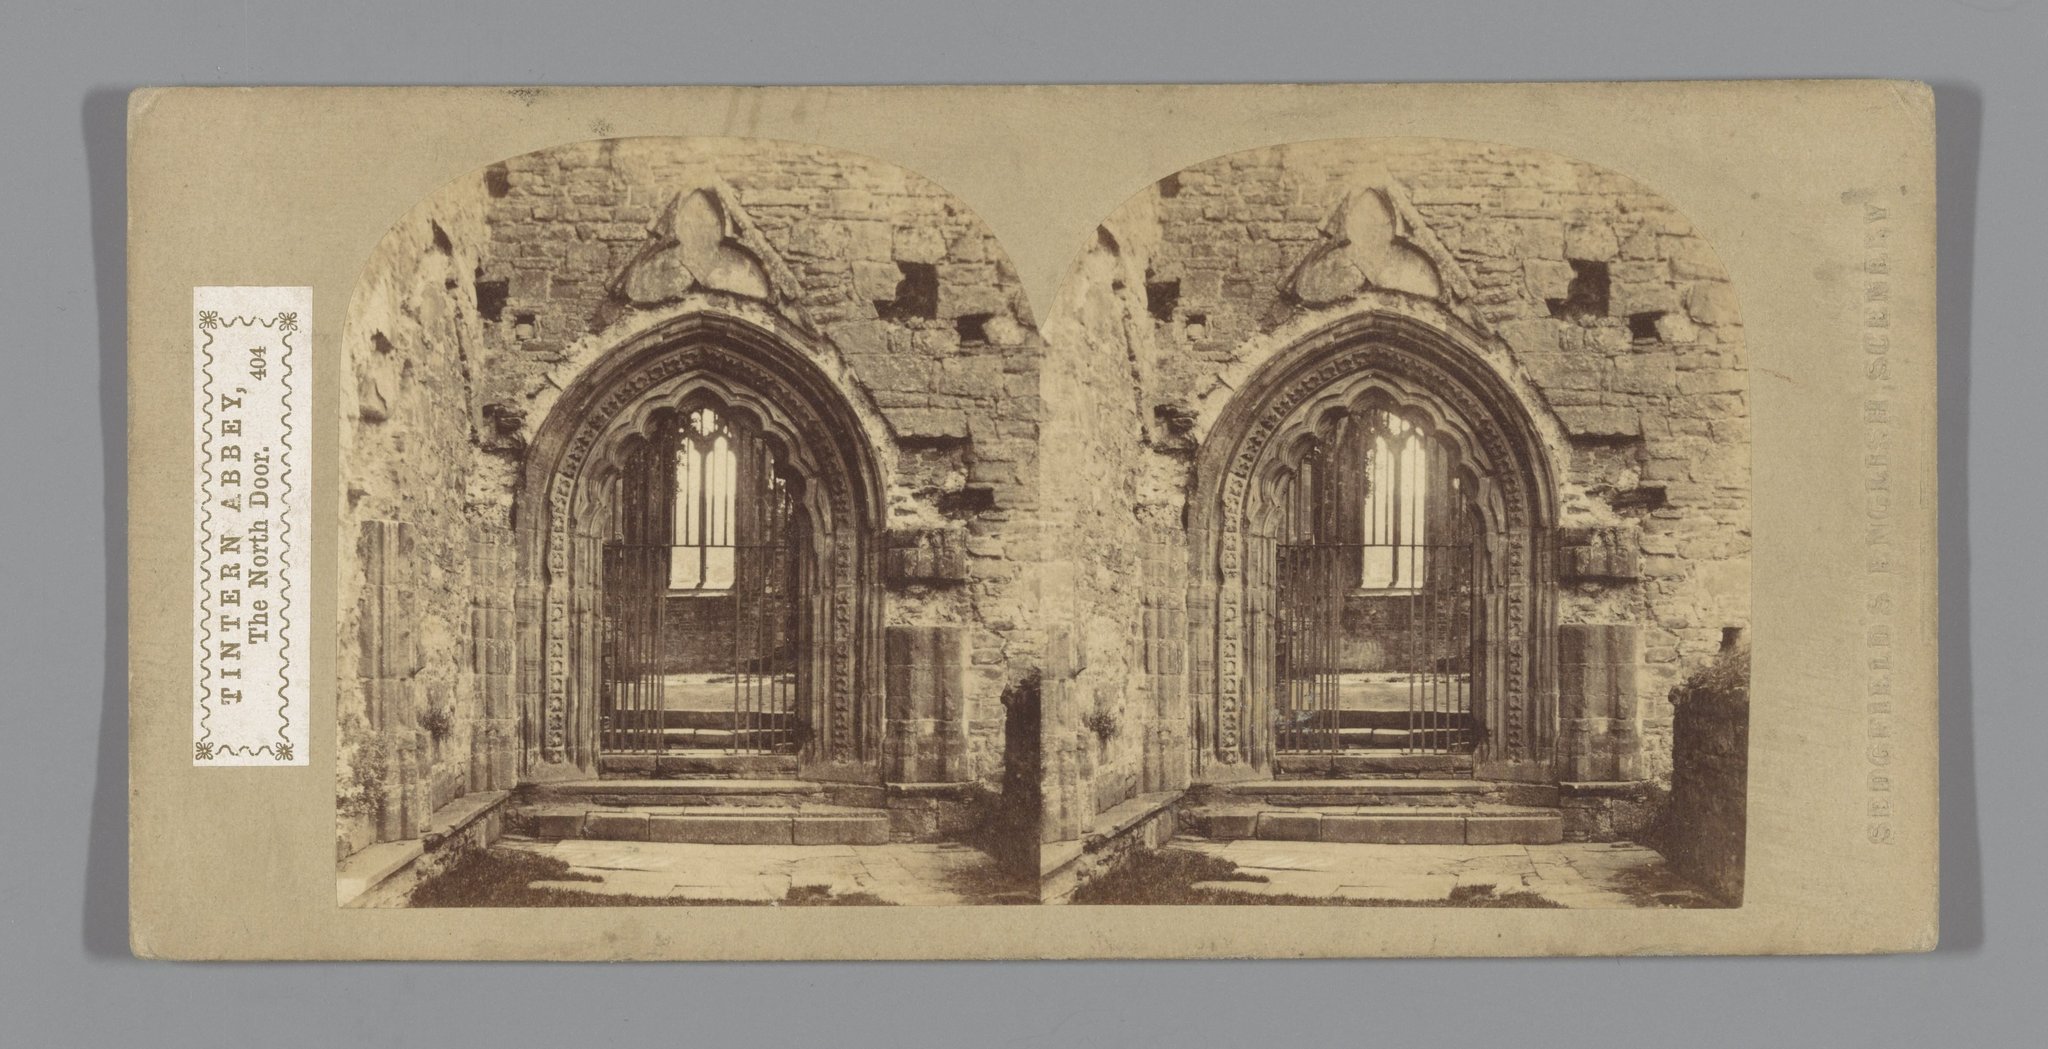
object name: stereograph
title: Tintern Abbey, The North Door.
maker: william russell sedgfield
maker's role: fotograaf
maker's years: 1826-1902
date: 1850-1880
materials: cardboard, photographic support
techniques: albumen print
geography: tintern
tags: parts of church exterior and annexes: portal, ruin of church, monastery, etc.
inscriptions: number: ‘404’, inscription: ‘Sedgfield's English Scenery’